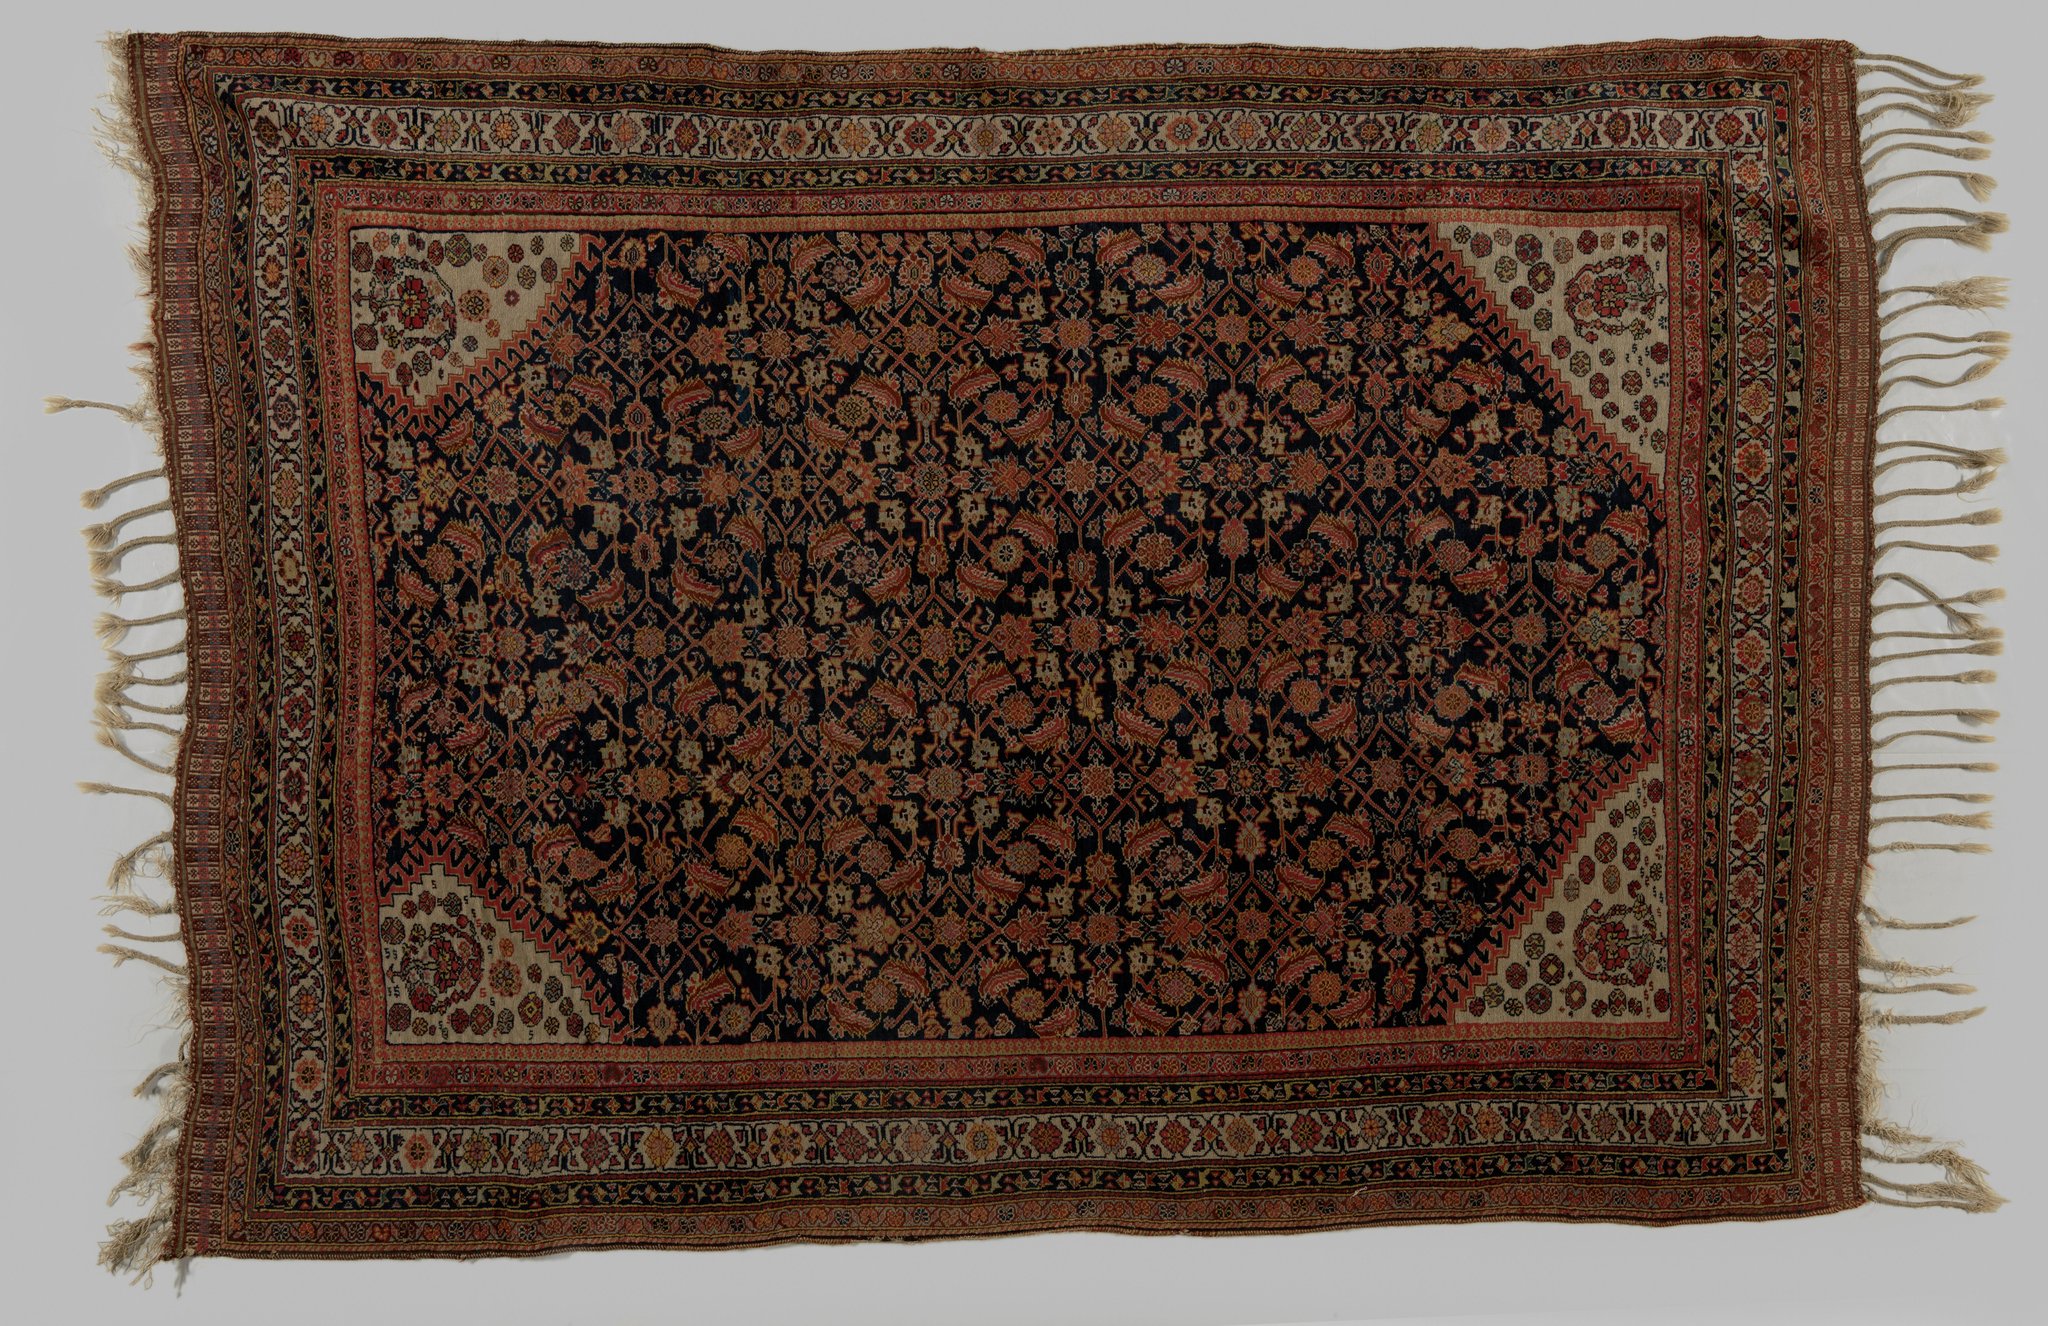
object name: oriental rug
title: Oosters tapijt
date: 1885-1949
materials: wool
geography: shiraz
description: Oosters tapijt met Herati-patroon, in de hoeken witte segmenten met uit bloemen en bloemknoppen samengestelde boteh's en geometrische strooimotiefjes. Zes randen waarvan de middelste, de breedste, versierd is met dubbelranken en rozetten. Lange gevlochte franje. Vervaardigd door Qushgai wevers.